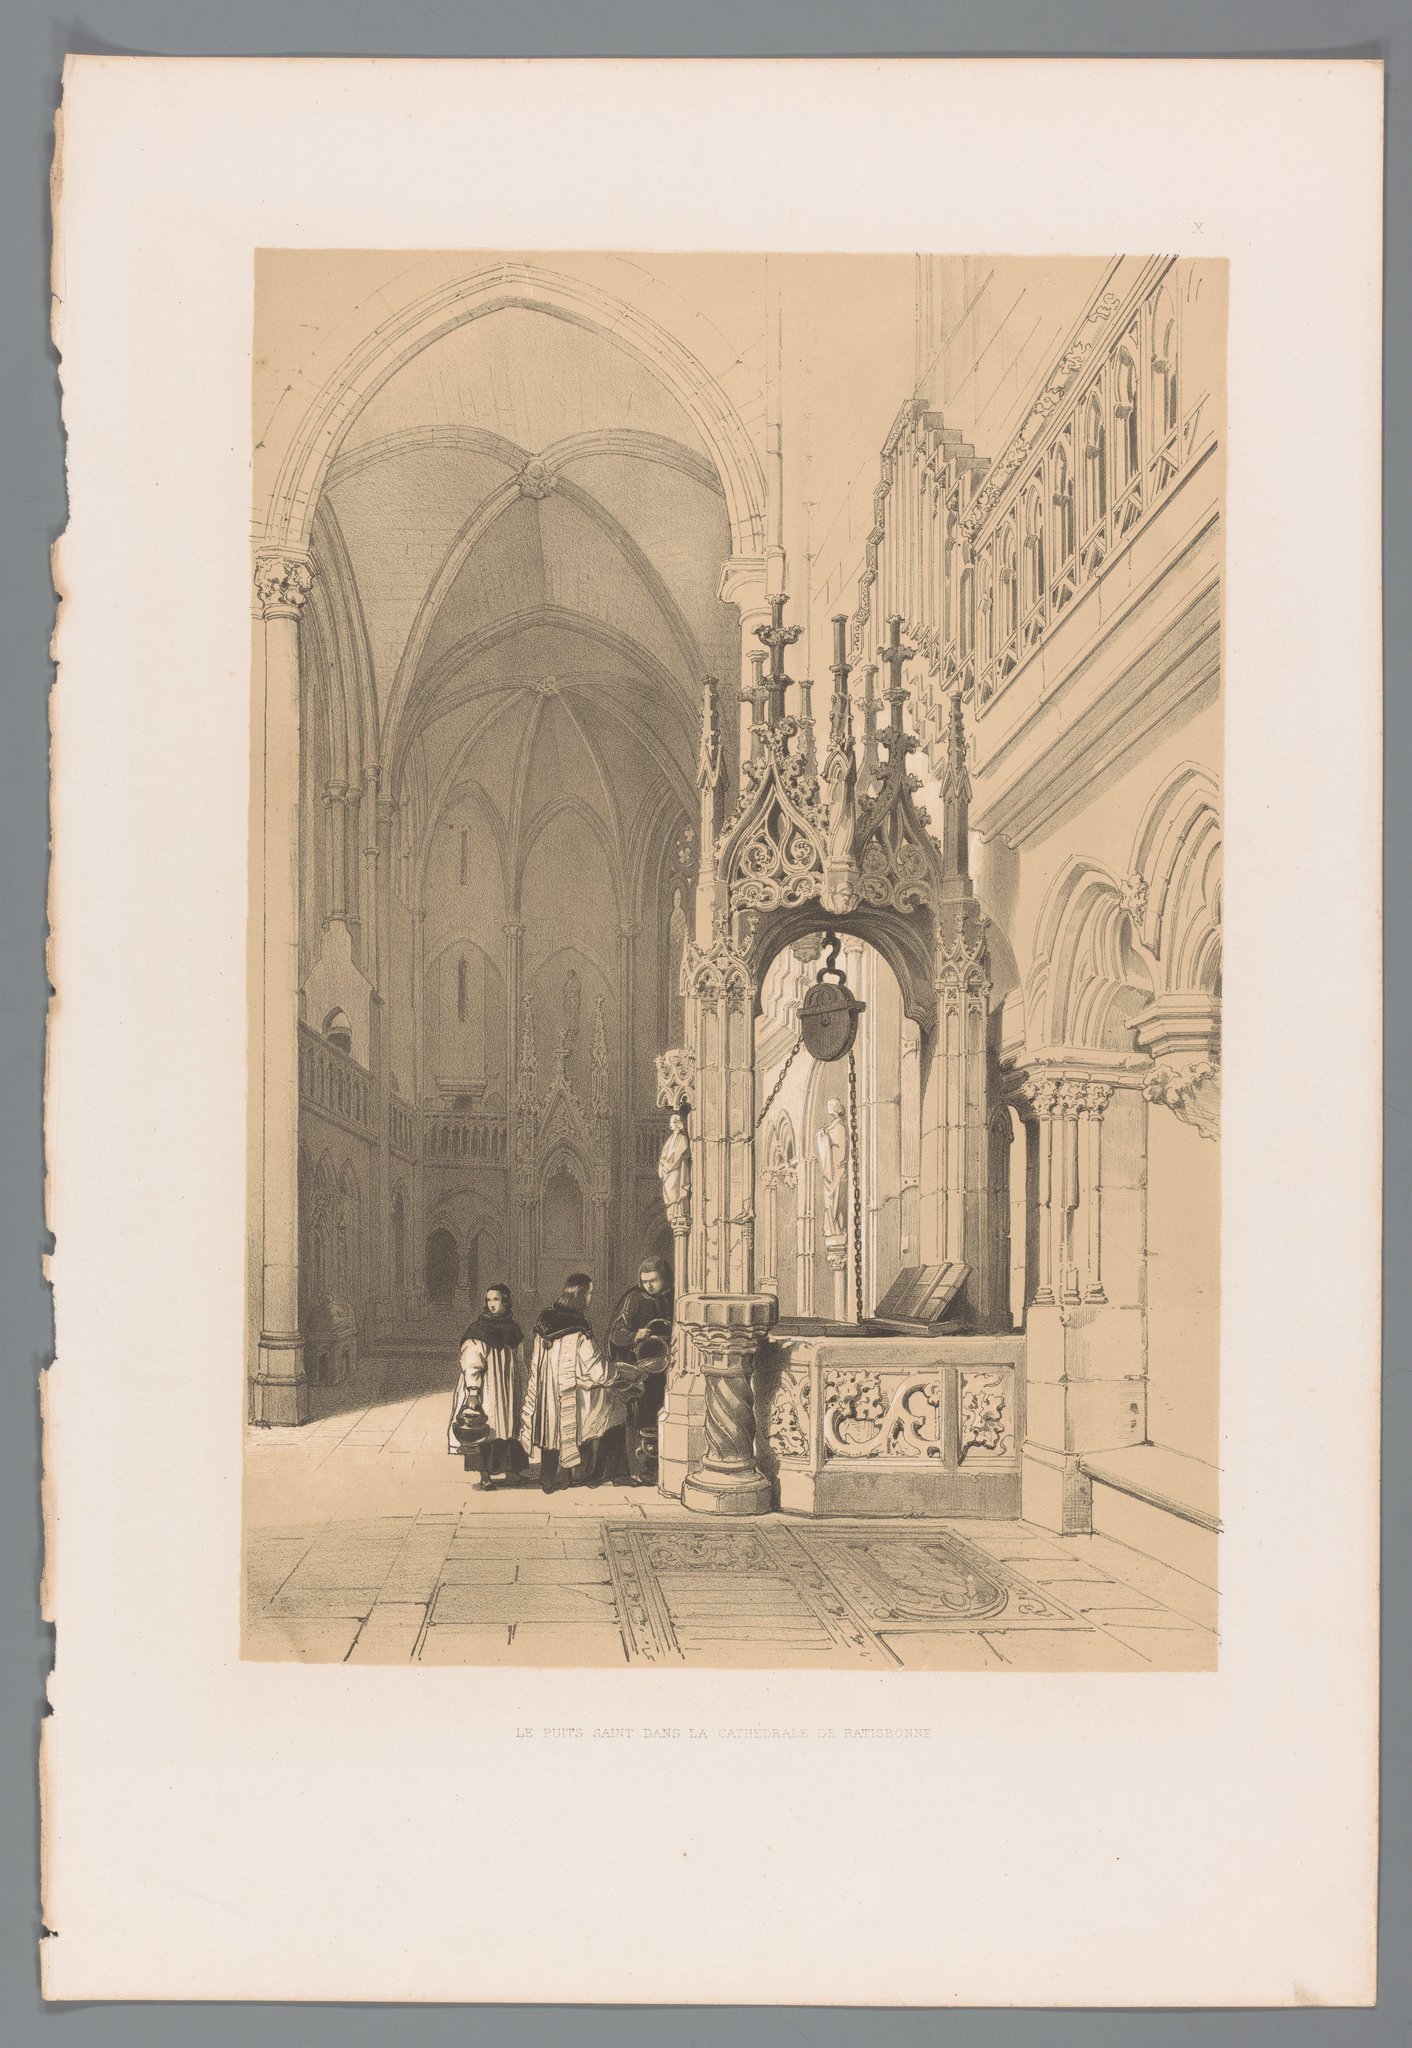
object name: print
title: Le puits saint dans la Cathédrale de Ratisbonne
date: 1845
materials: paper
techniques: tone lithography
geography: brussels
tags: well, interior of church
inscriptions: collector's mark: Lugt 2228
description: Prent uit: Haghe, Louis en Octave Delepierre. Monuments Anciens recueillis en Allemagne. Brussel en Leipzig: C. Muquardt, 1845.